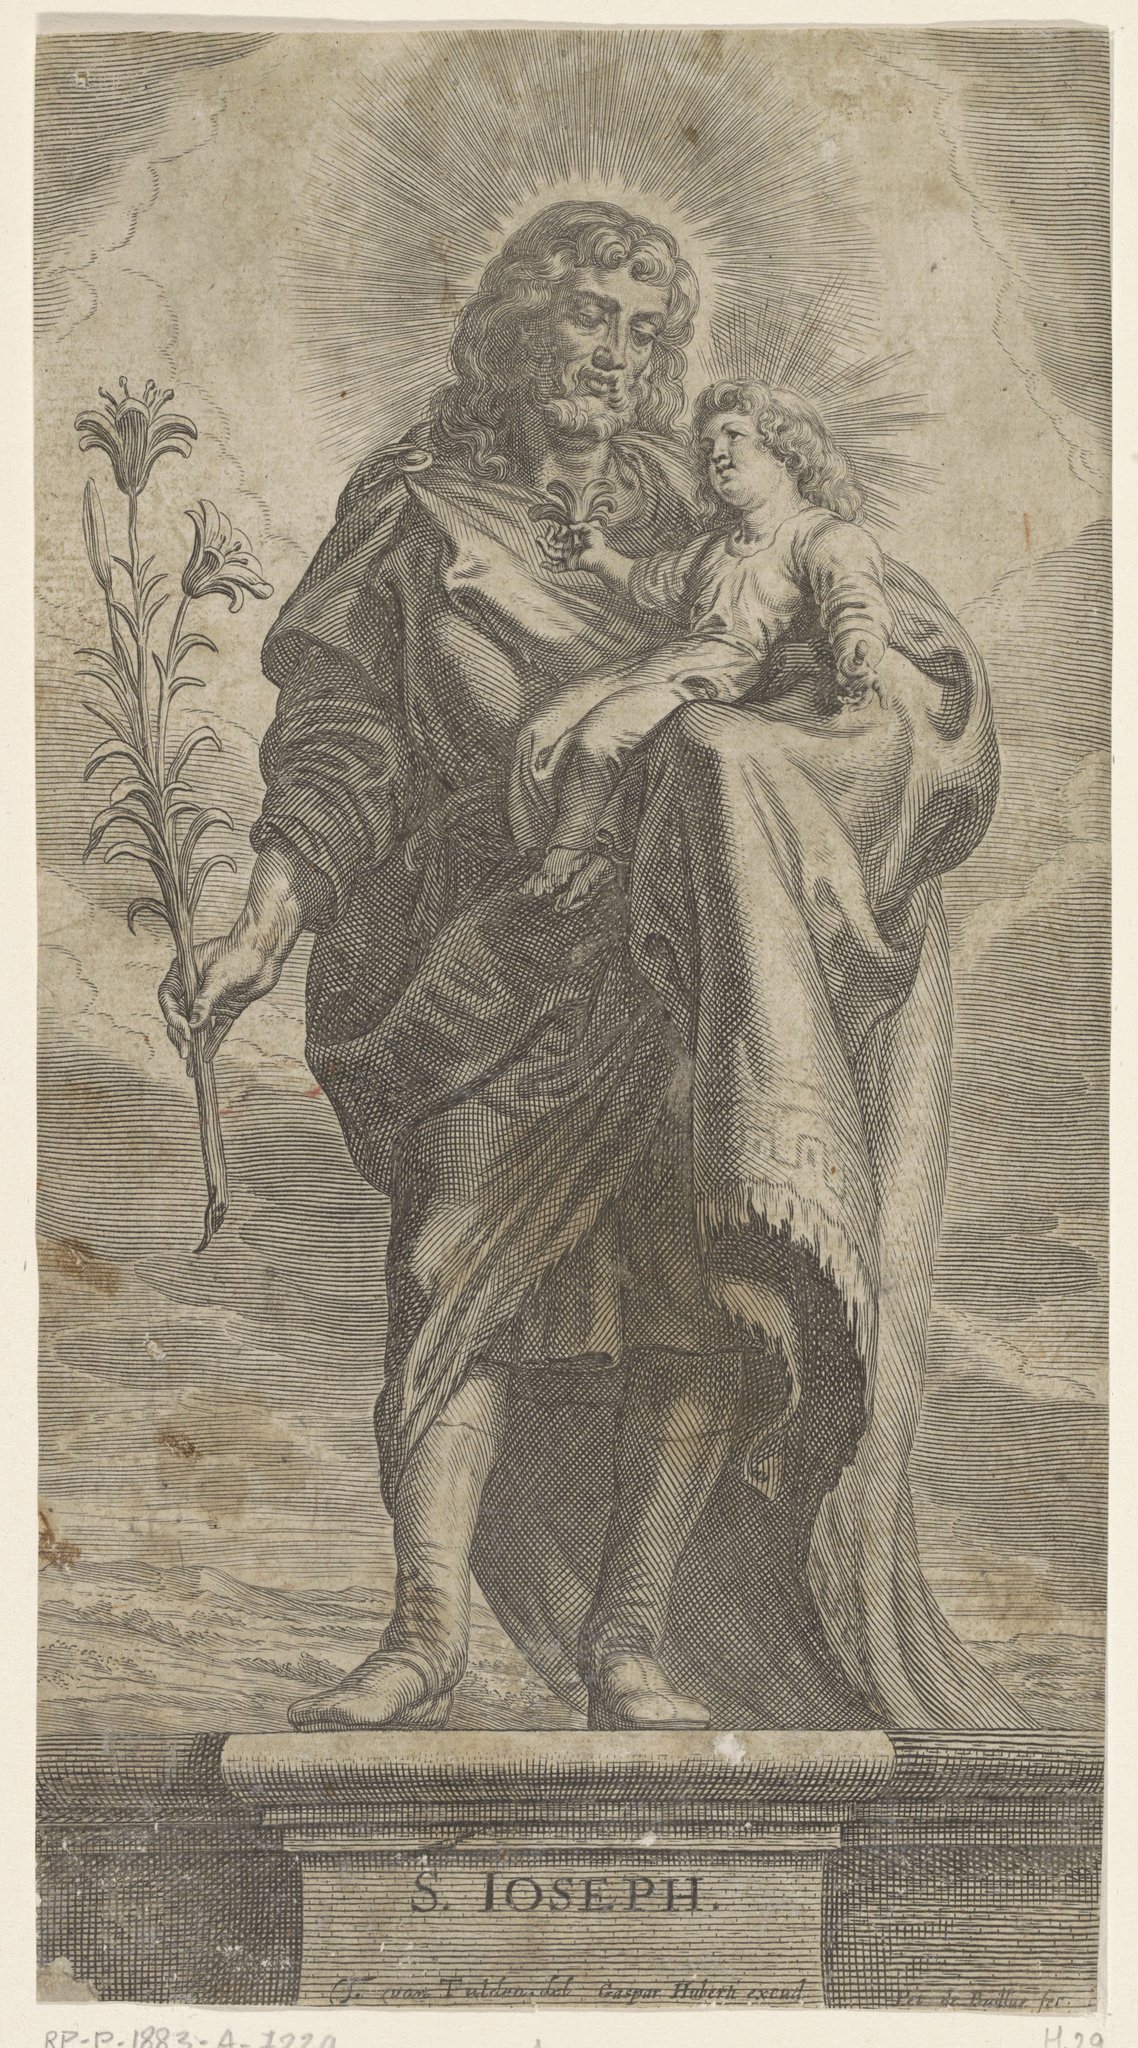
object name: print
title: Christus en Maria en heiligen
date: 1623-1660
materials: paper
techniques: engraving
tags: the foster-father of christ, joseph of nazareth, husband of mary; possible attributes: flowering rod or wand, lily, carpenter's tools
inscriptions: collector's mark: Lugt 2228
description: Prent naar ontwerp van Theodoor van Thulden uit een serie van zestien prenten met Christus, Maria, de twaalf apostelen en de heiligen Paulus en Jozef.